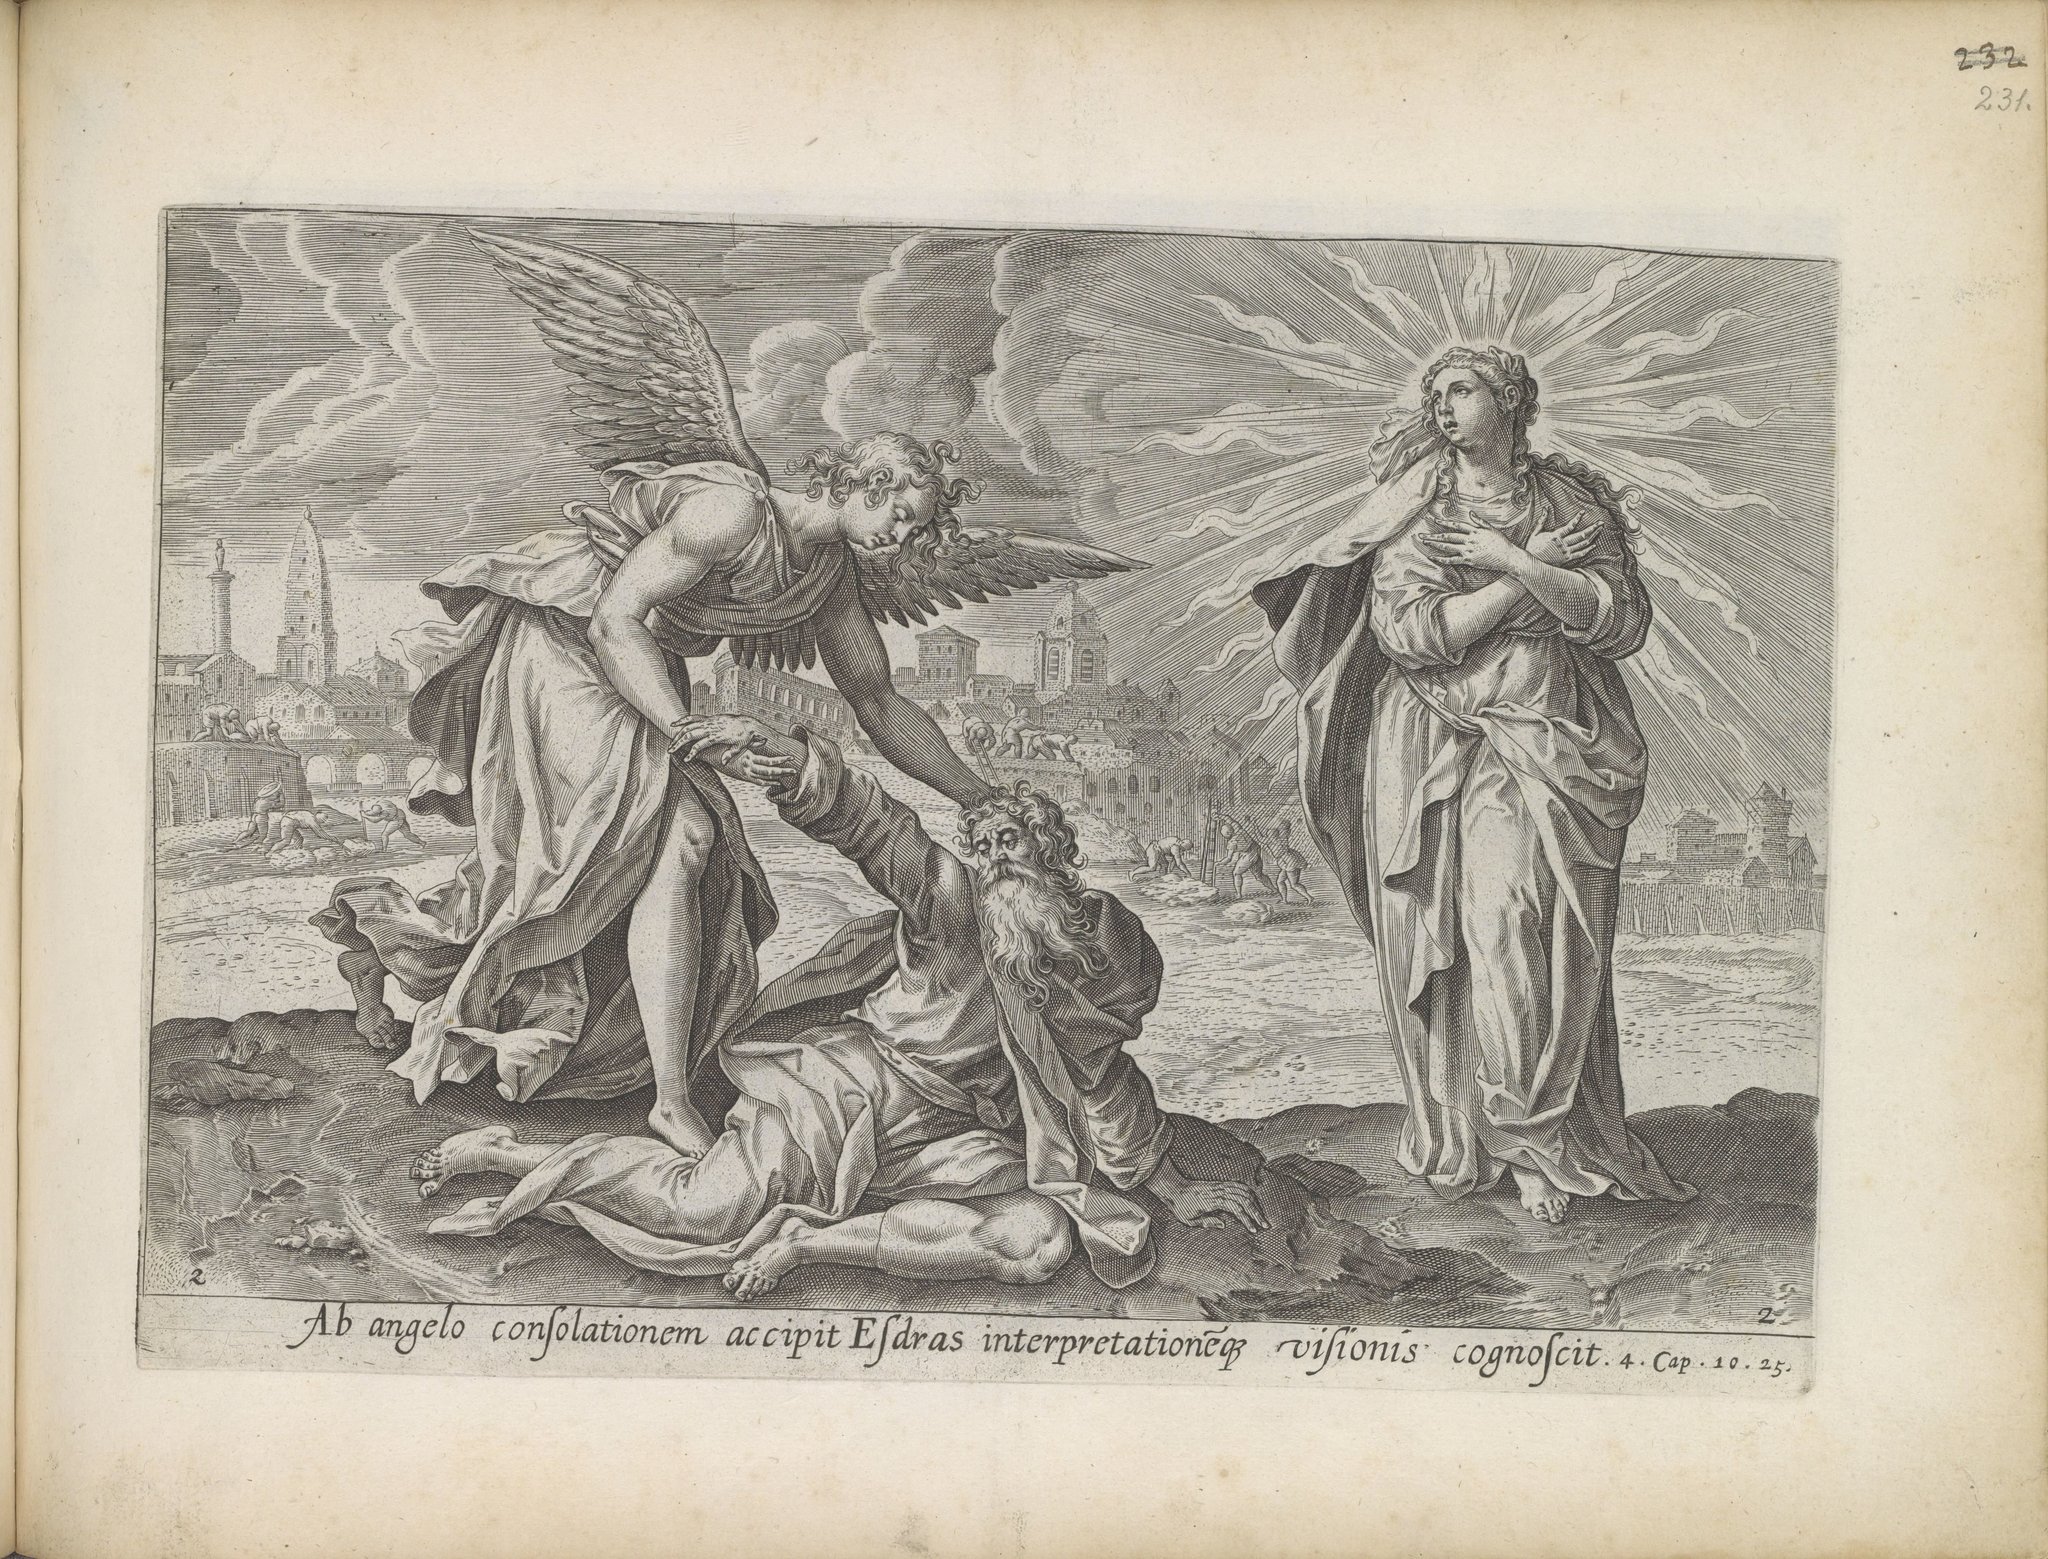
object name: print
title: Theatrum Biblicum Hoc Est Historiae Sacrae Veteris et Novi Testamenti Tabulis Aeneis Expressae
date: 1585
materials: paper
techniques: engraving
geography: amsterdam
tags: other scenes from ezra and esdras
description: De engel Uriël troost Ezra en helpt hem overeind. Naast Ezra zijn visioen van de stralende vrouw Sion. Als zij verdwijnt ziet Ezra de stad die wordt gebouwd op de achtergrond. Onder de voorstelling een verwijzing in het Latijn naar de apocriefe Bijbeltekst in 4 Ezra 10:25. Deze prent maakt deel uit van een album.